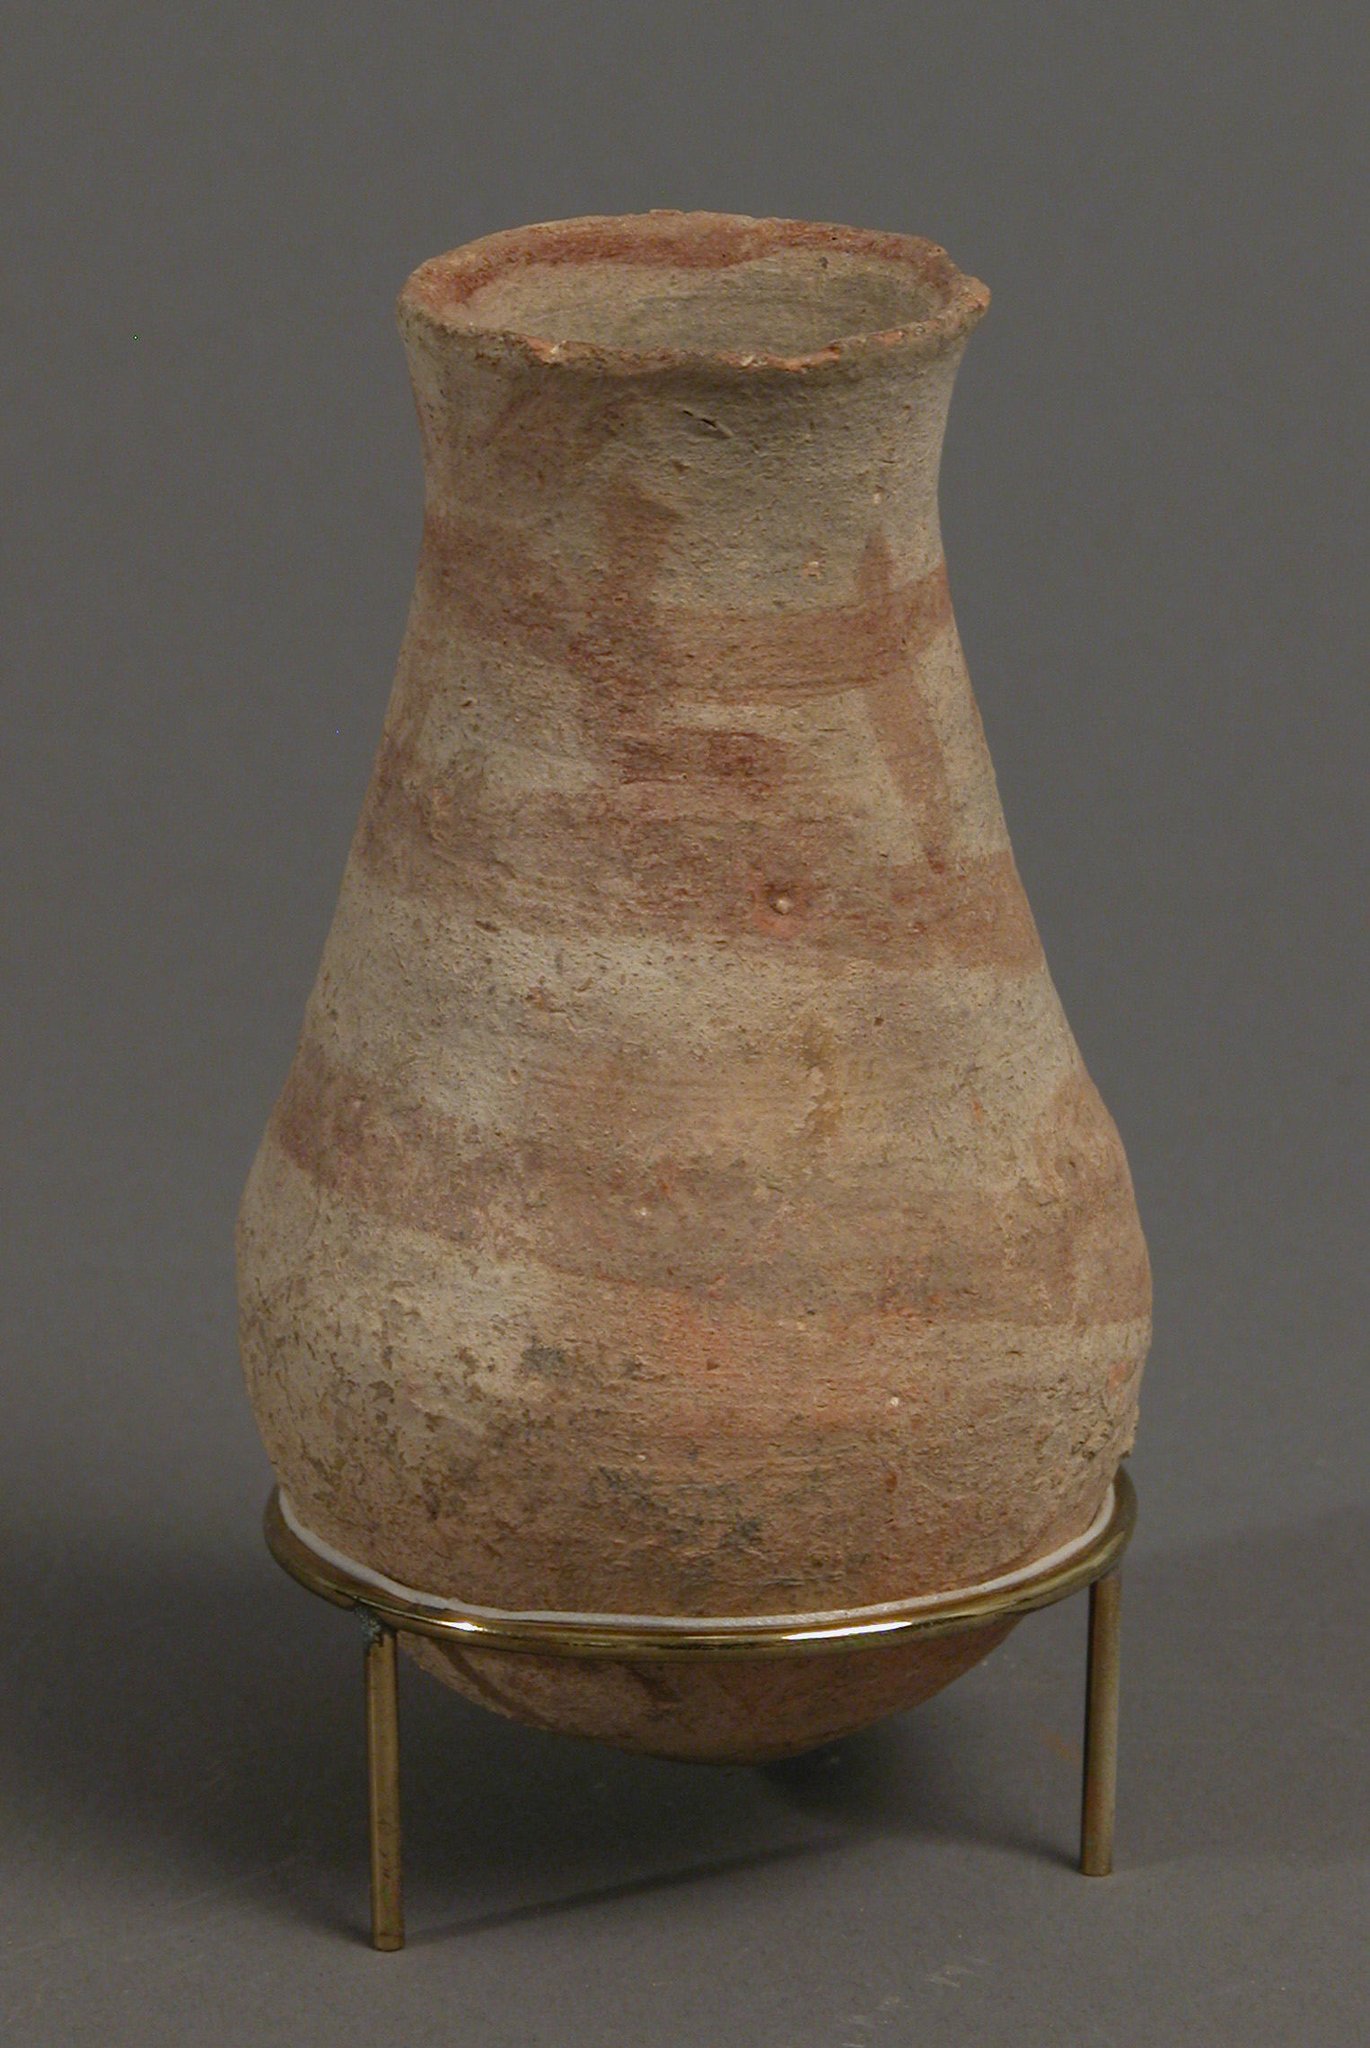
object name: jug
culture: coptic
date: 301-700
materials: earthenware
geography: egypt